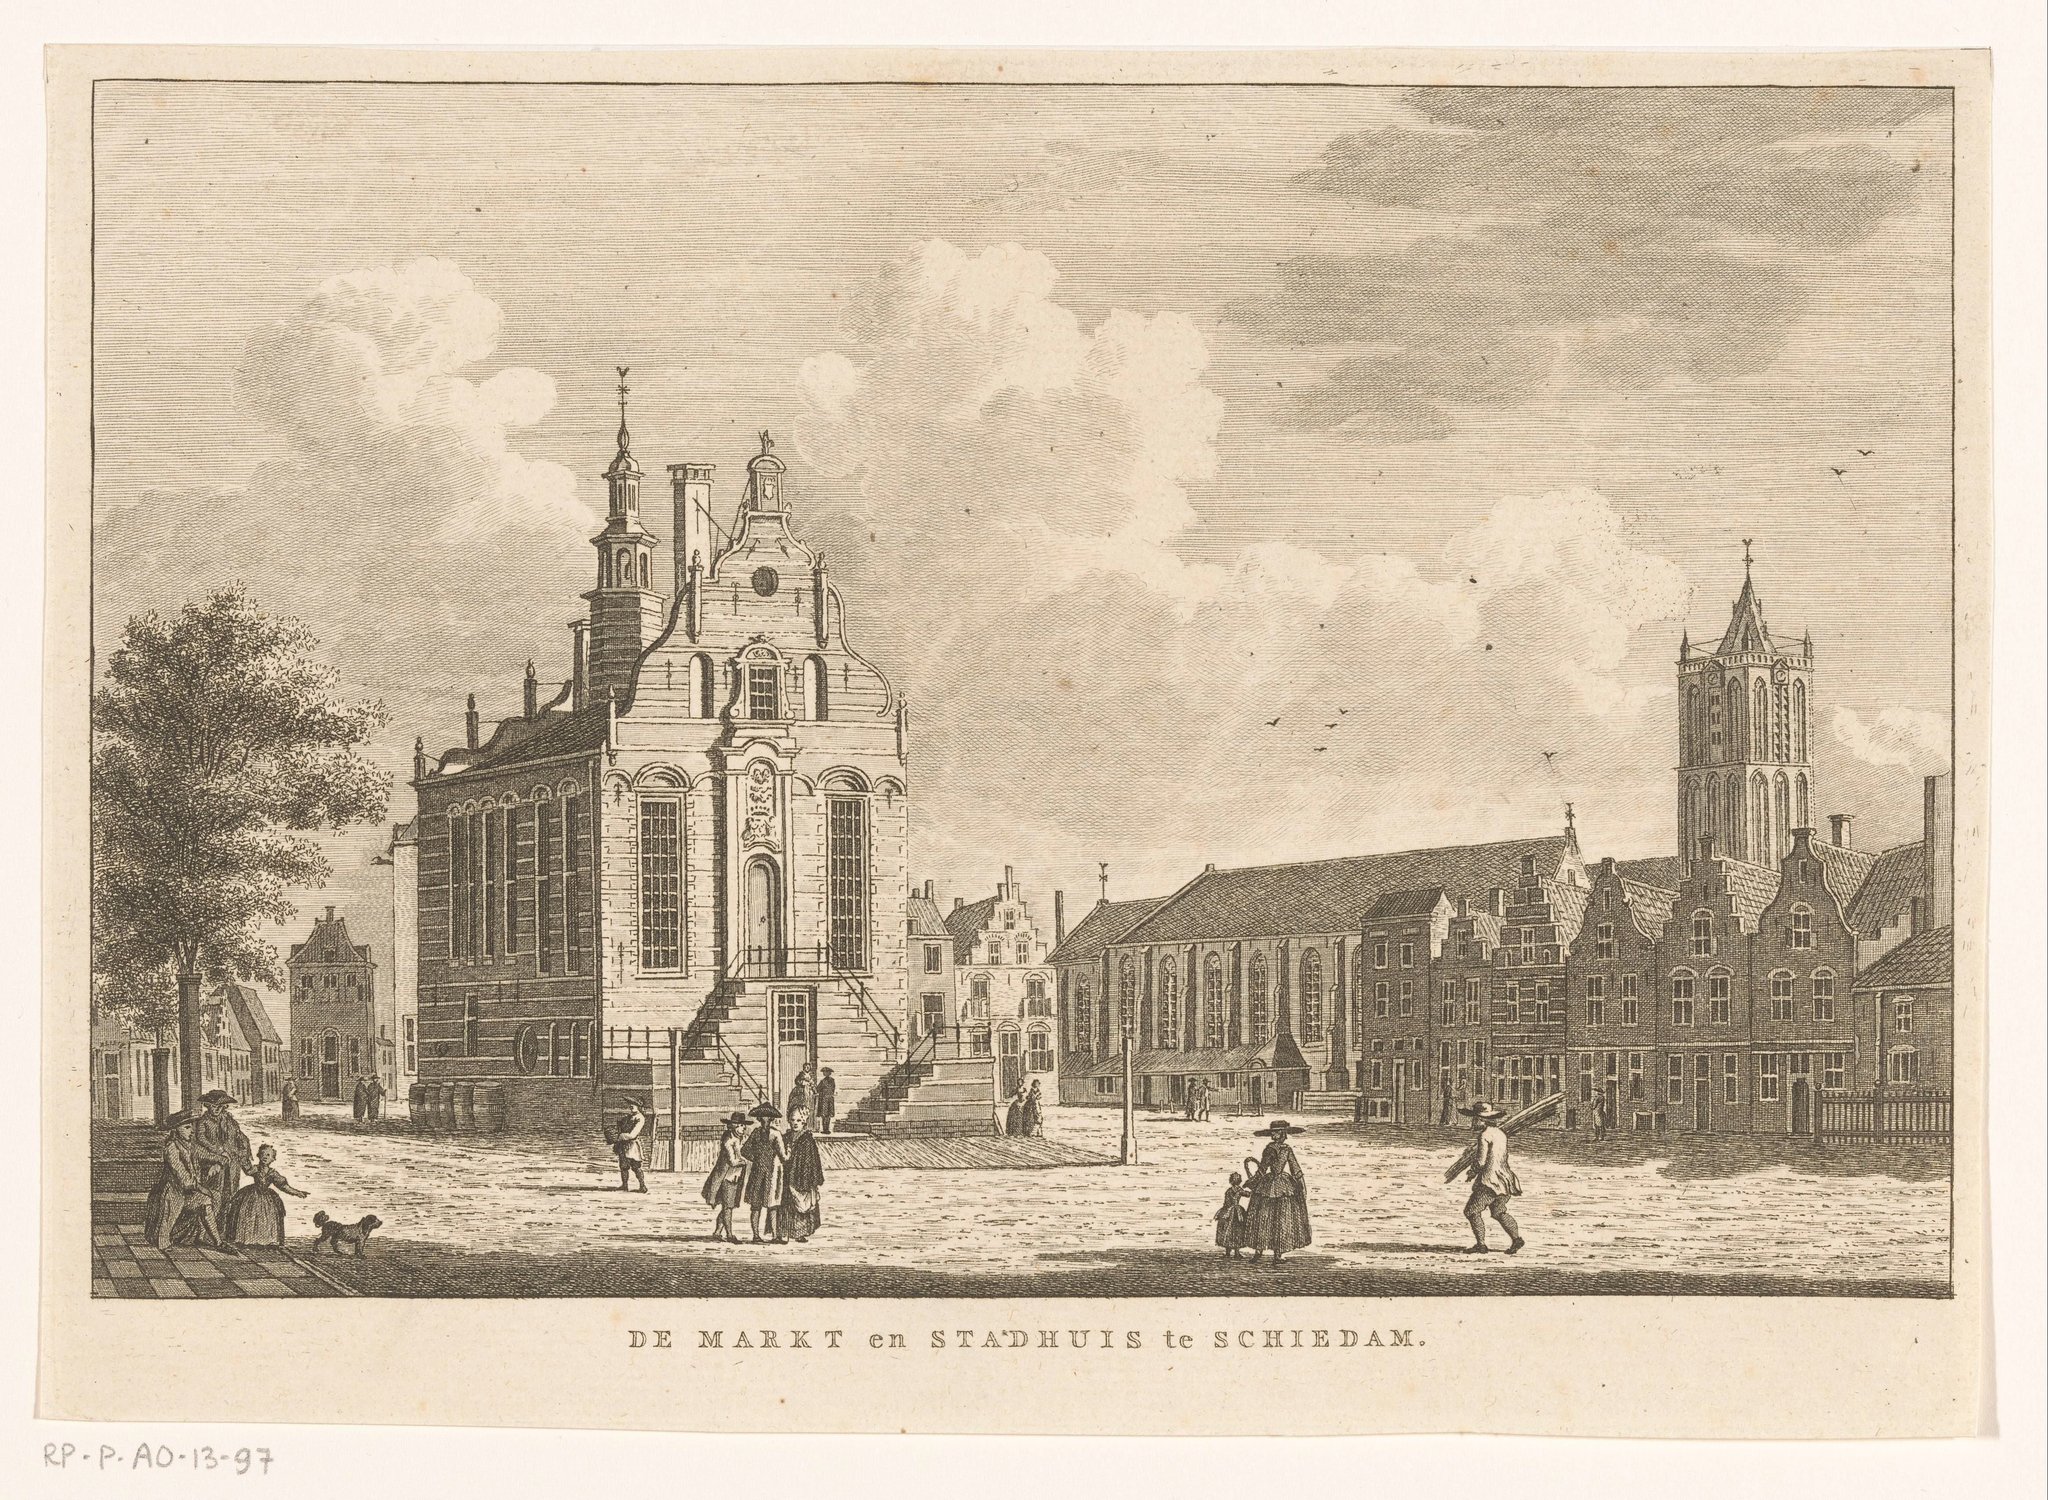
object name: print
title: Gezicht op het Oude Stadhuis te Schiedam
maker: carel frederik bendorp (i)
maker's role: print maker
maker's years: 1736-1814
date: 1786-1792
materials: paper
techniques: engraving, etching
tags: church (exterior), townhall, square, place, circus, etc. (+ city(-scape) with figures, staffage)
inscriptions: collector's mark: Lugt 195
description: Prent uit: Vaderlandsche gezichten, of afbeeldingen van den tegenwoordigen staat der Vereenigde Nederlanden (…). Amsterdam: Hendrik Gartman, Willem Vermandel en Jan Willem Smit, 1786-1792. Uitgegeven in afleveringen met ieder een eigen bifolium en inhoudsopgave. Alle prenten in deze publicatie zijn gegraveerd door Carel Frederik Bendorp (I) en, in de meeste gevallen, gebaseerd op tekeningen van Jan Bulthuis.